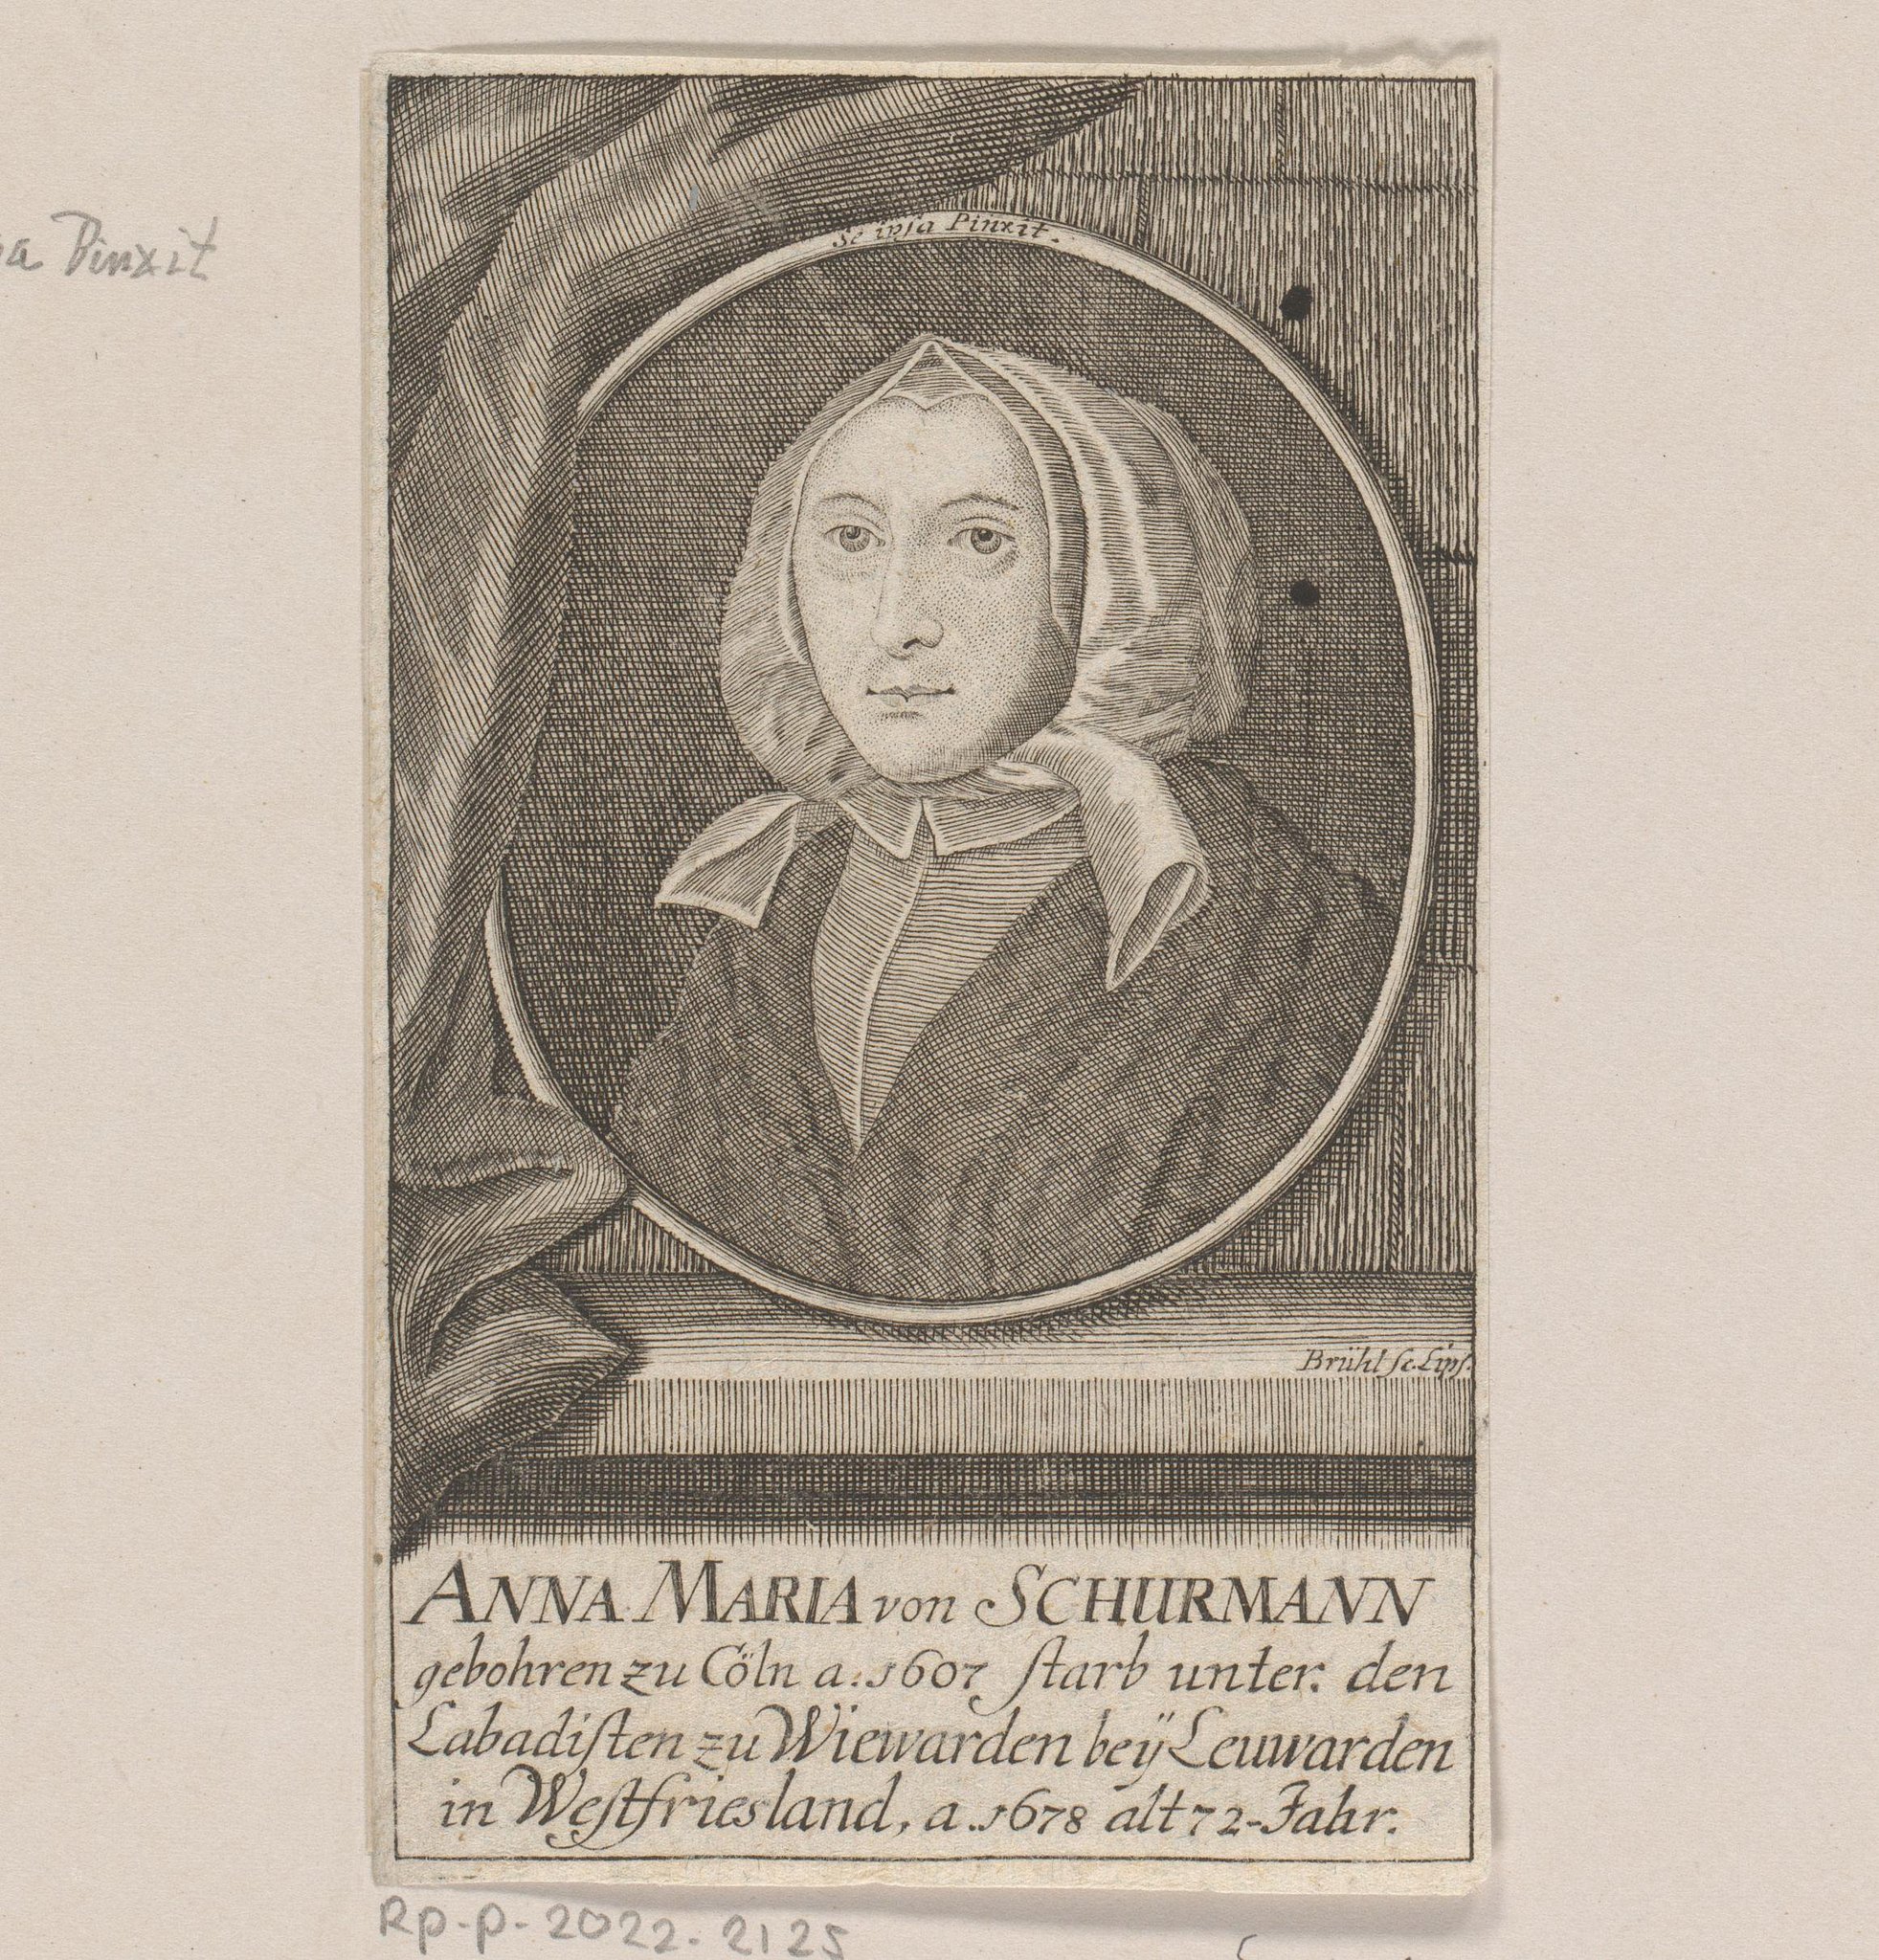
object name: print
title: Portret van Anna Maria van Schurman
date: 1701-1763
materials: paper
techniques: engraving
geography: leipzig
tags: cologne, print maker, draughtsman, anna maria van schurman, historical persons - bb - woman, portrait, self-portrait of artist, writer, poet, author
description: Met vierregelig onderschrift in het Duits.